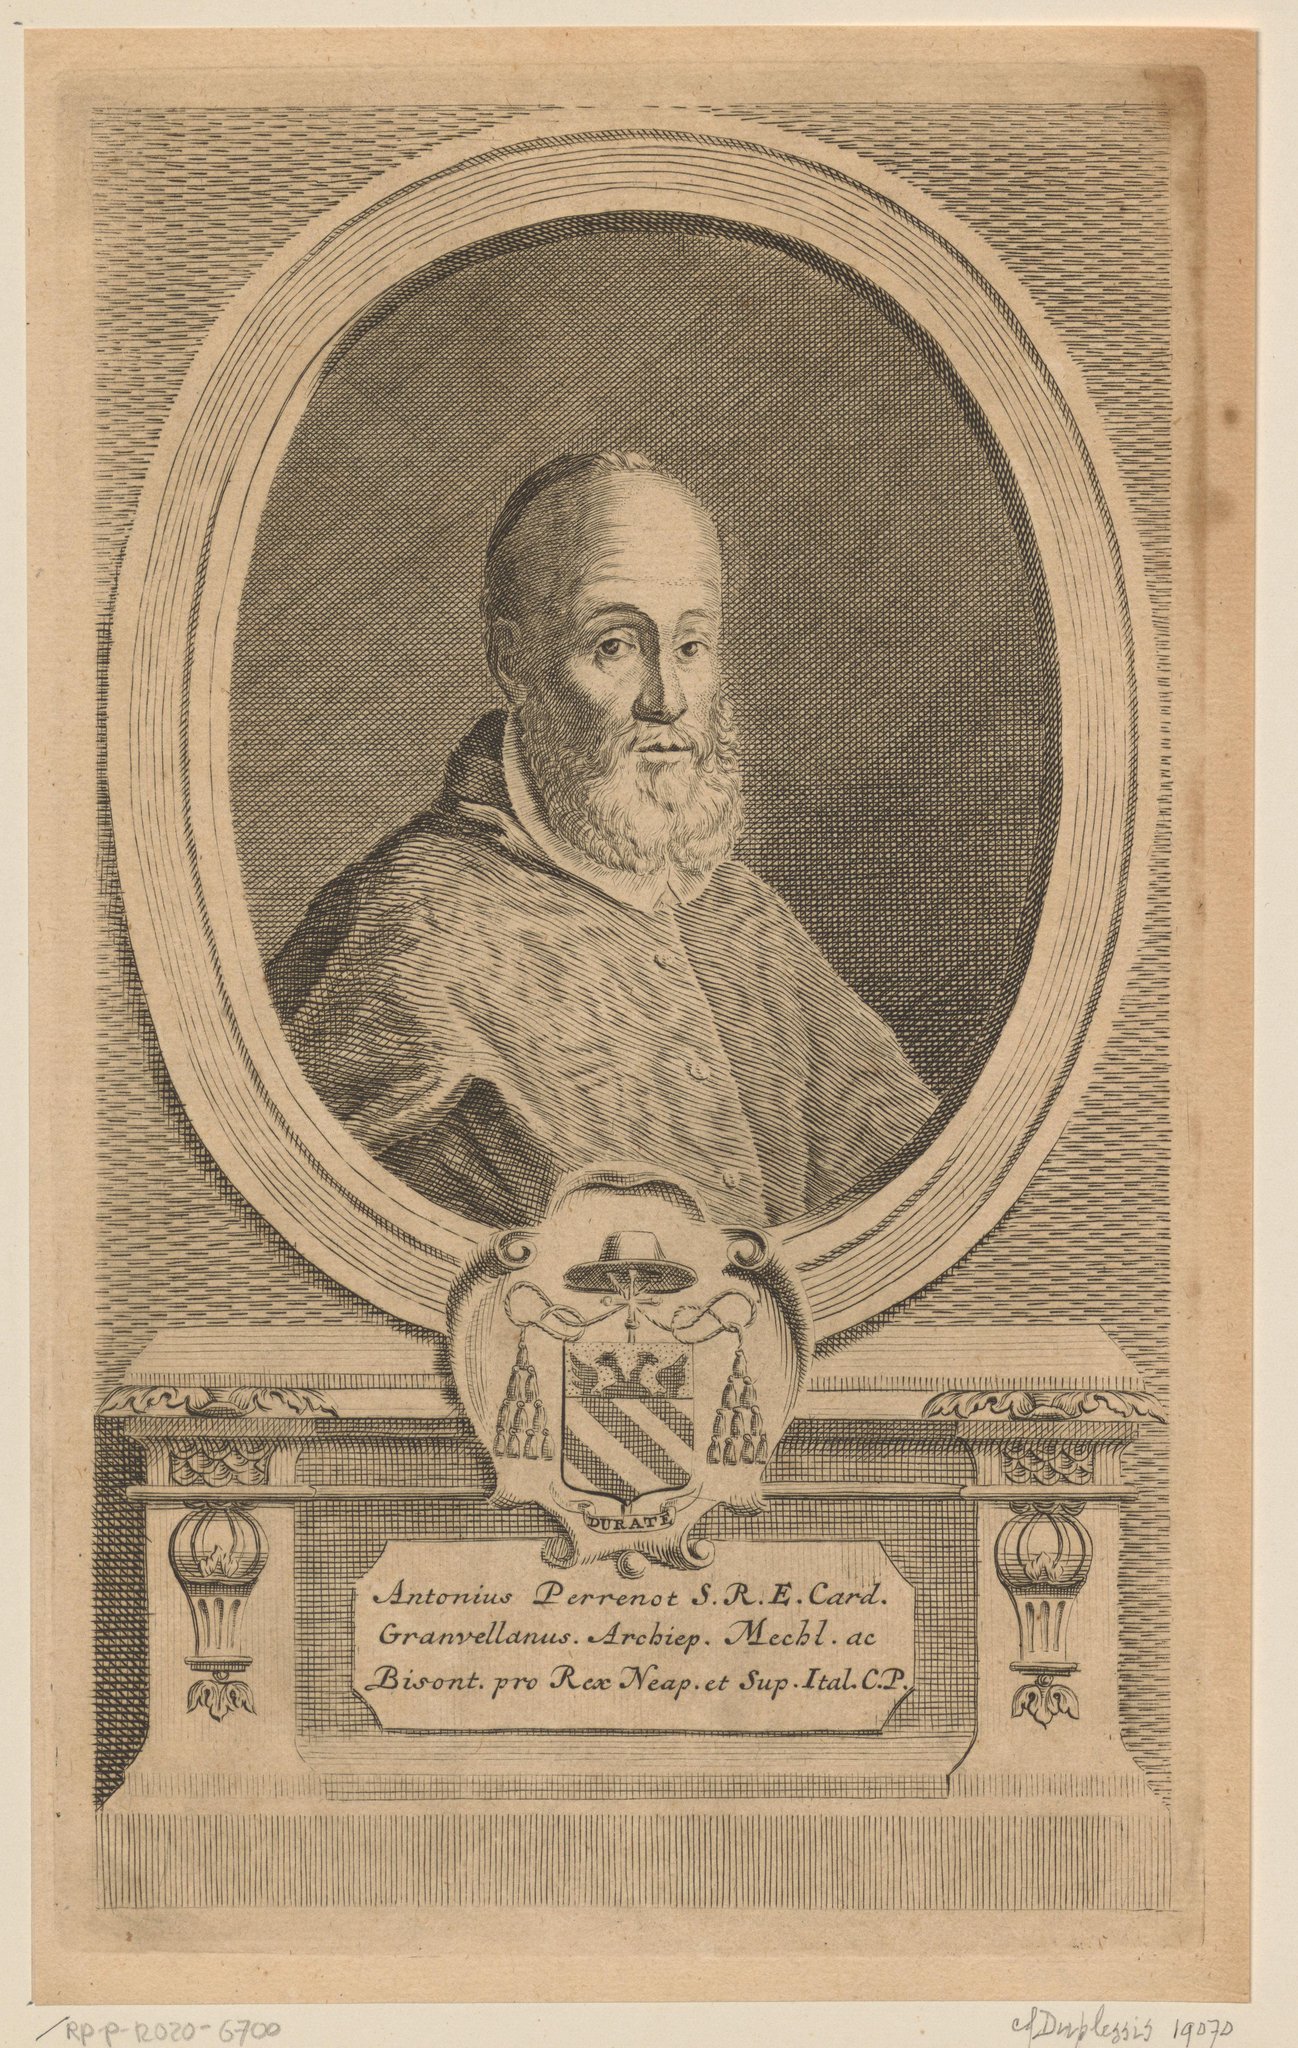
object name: print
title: Portret van Antoine Perrenot de Granvelle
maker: Anonymous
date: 1600-1700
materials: paper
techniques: engraving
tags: antoine perrenot de granvelle, cardinal, historical persons